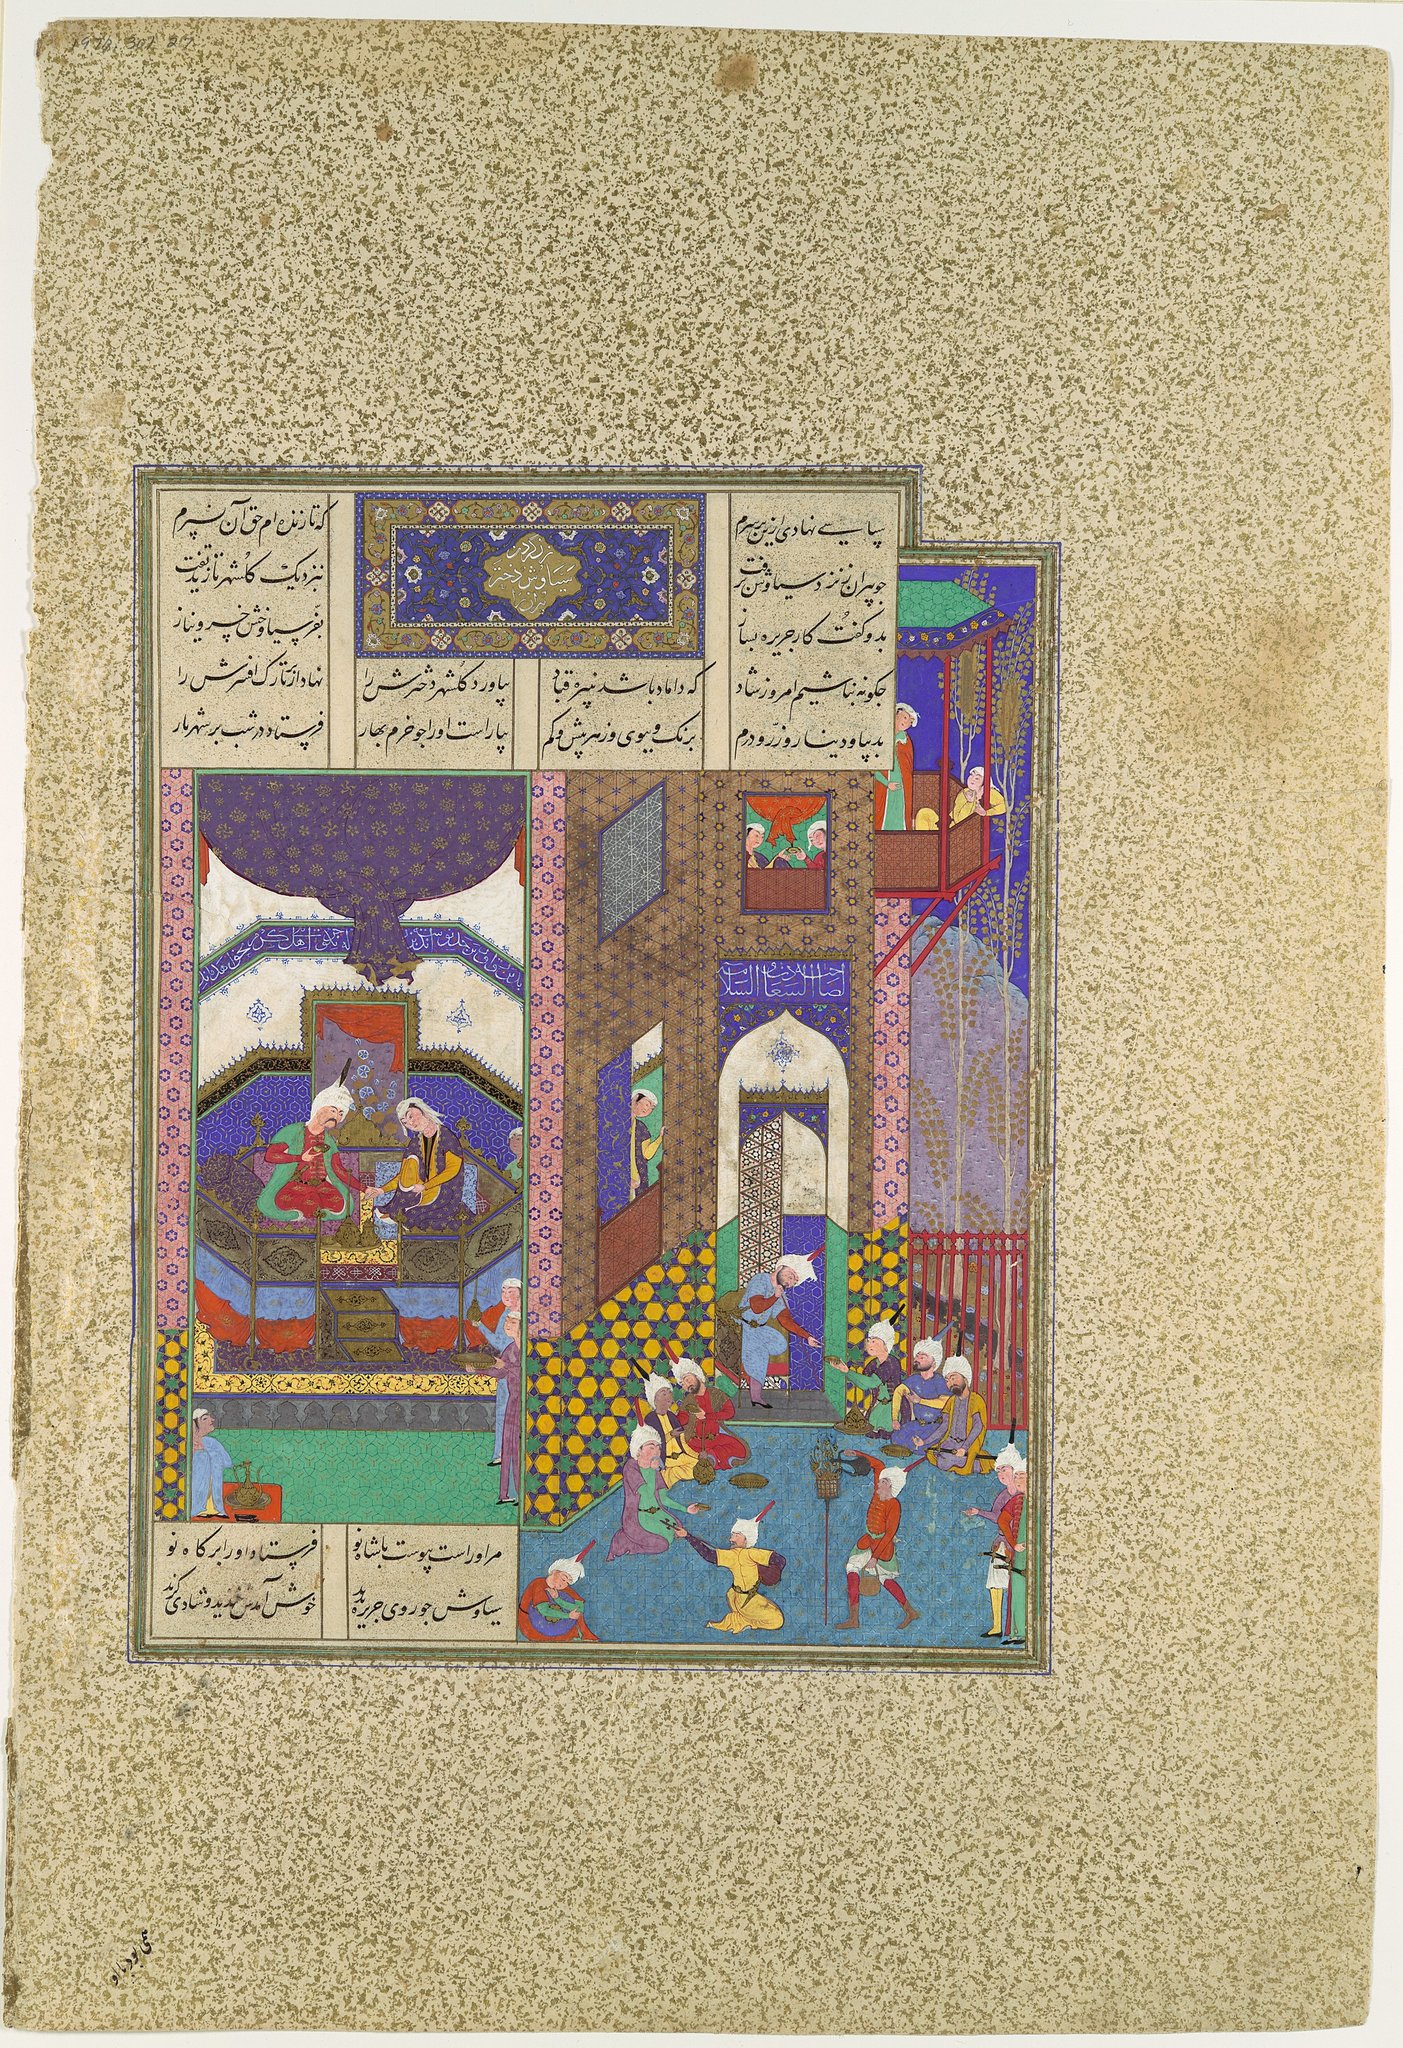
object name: folio from an illustrated manuscript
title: "Siyavush and Jarira Wedded", Folio 183v from the Shahnama (Book of Kings) of Abu'l Qasim Firdausi, commissioned by Shah Tahmasp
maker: abu'l qasim firdausi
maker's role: author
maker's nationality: iranian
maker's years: 935-1020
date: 1525-1530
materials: gold, ink, paper, silver, watercolor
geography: iran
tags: interiors,men,women,music